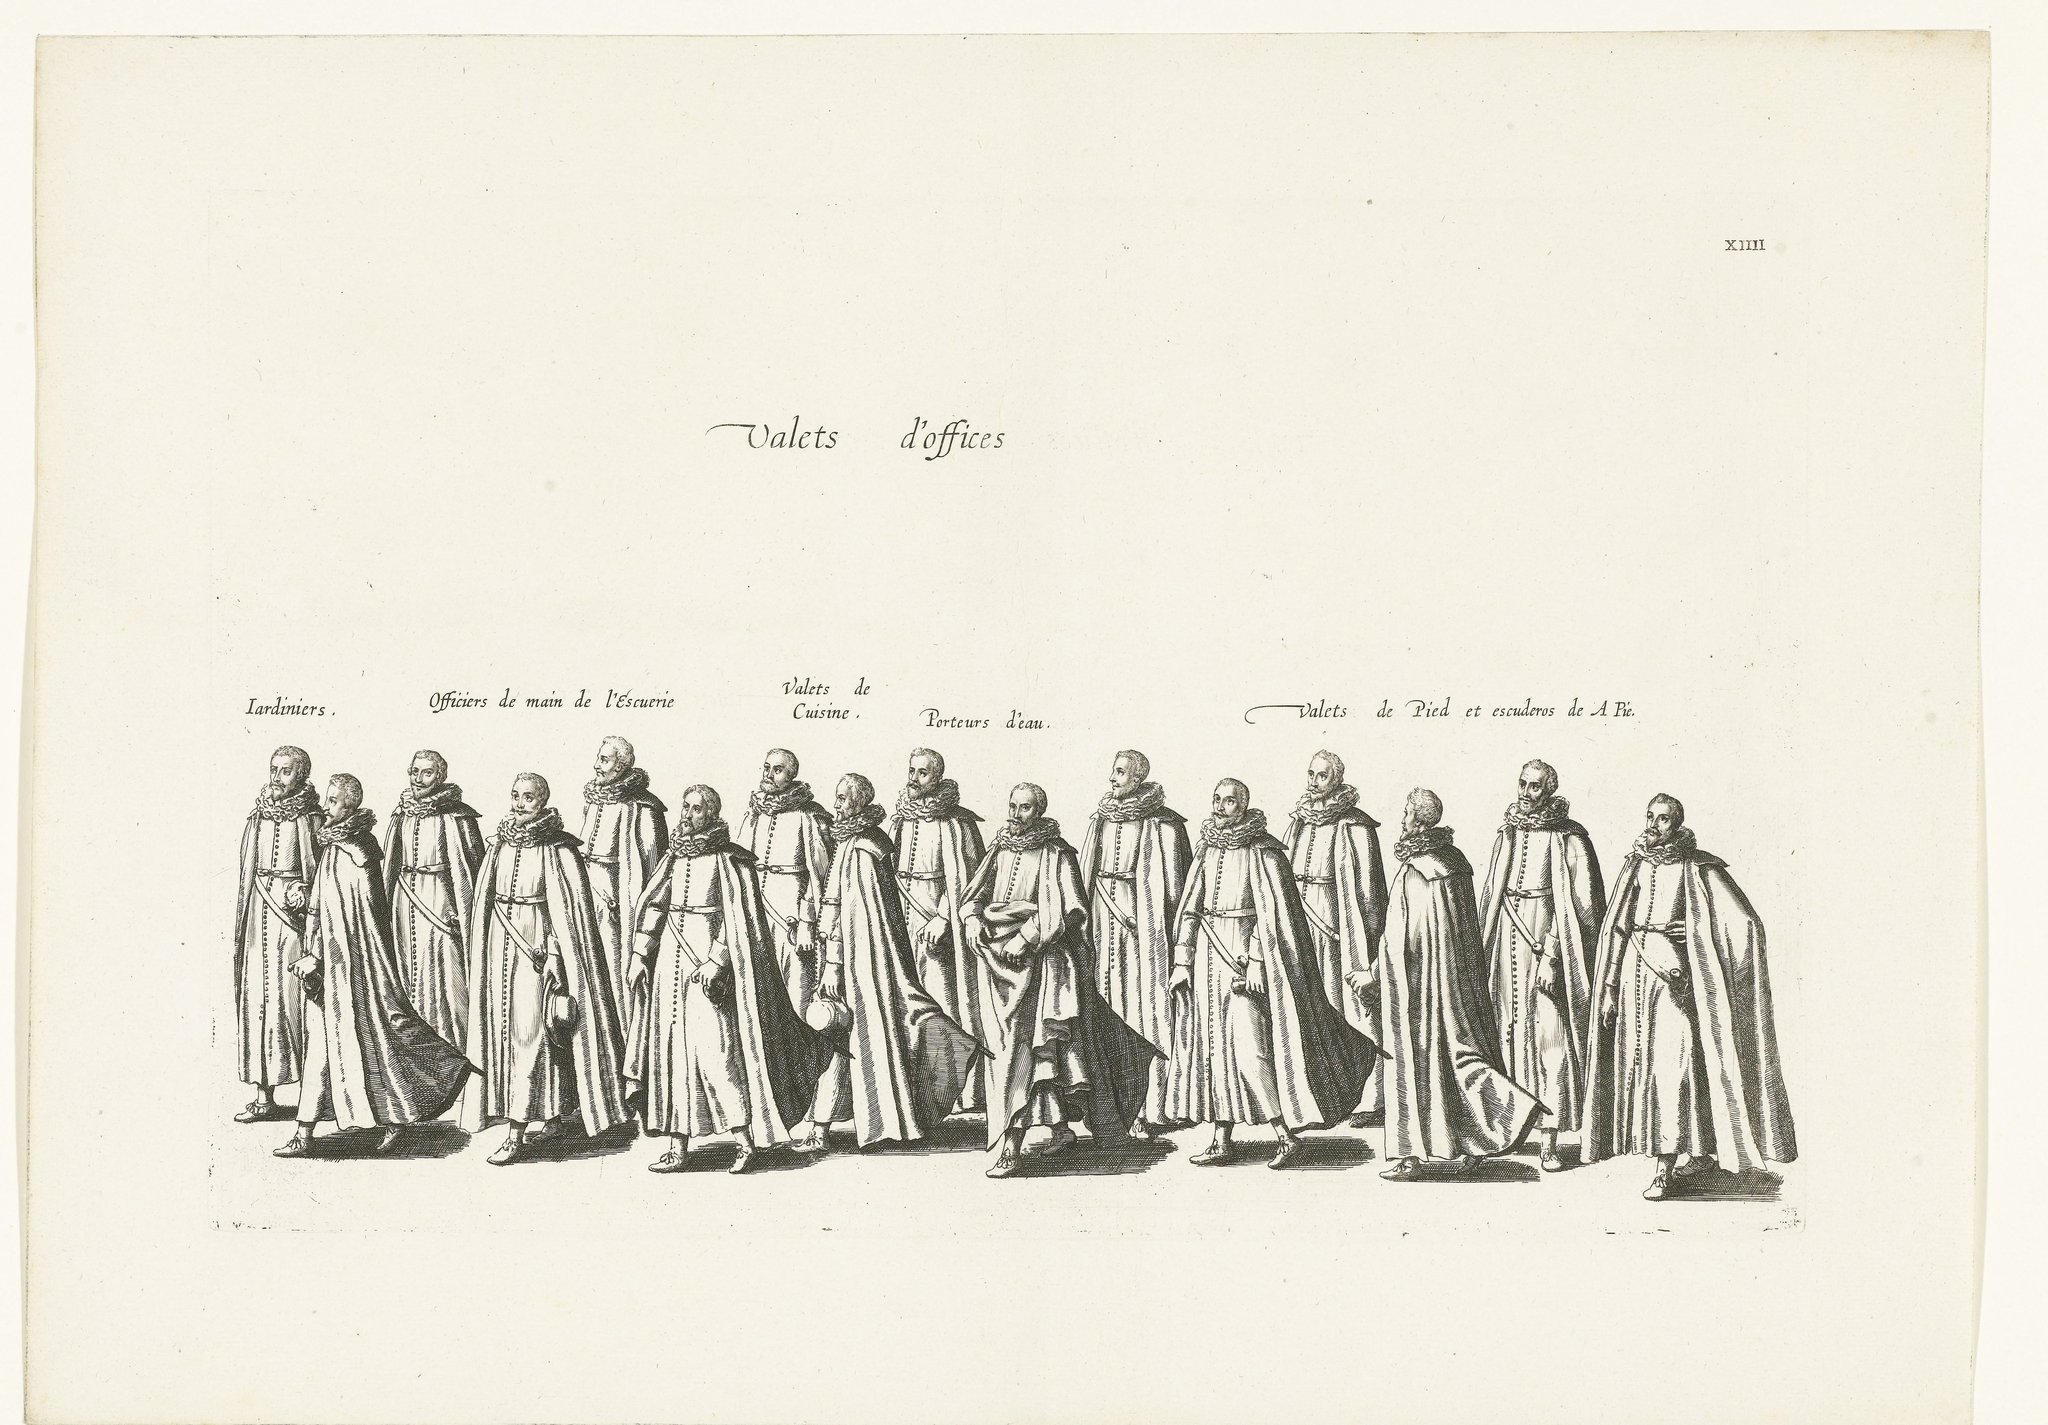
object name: print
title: Valets d'offices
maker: cornelis galle (i)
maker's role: print maker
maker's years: 1576-1650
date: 1623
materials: paper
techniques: etching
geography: southern netherlands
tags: brussels, albrecht aartshertog van oostenrijk, cortege, funeral procession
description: Deelnemers aan de begrafenisstoet. Plaat XIIII in de serie van de begrafenis van aartshertog Albrecht van Oostenrijk te Brussel op 12 maart 1622.